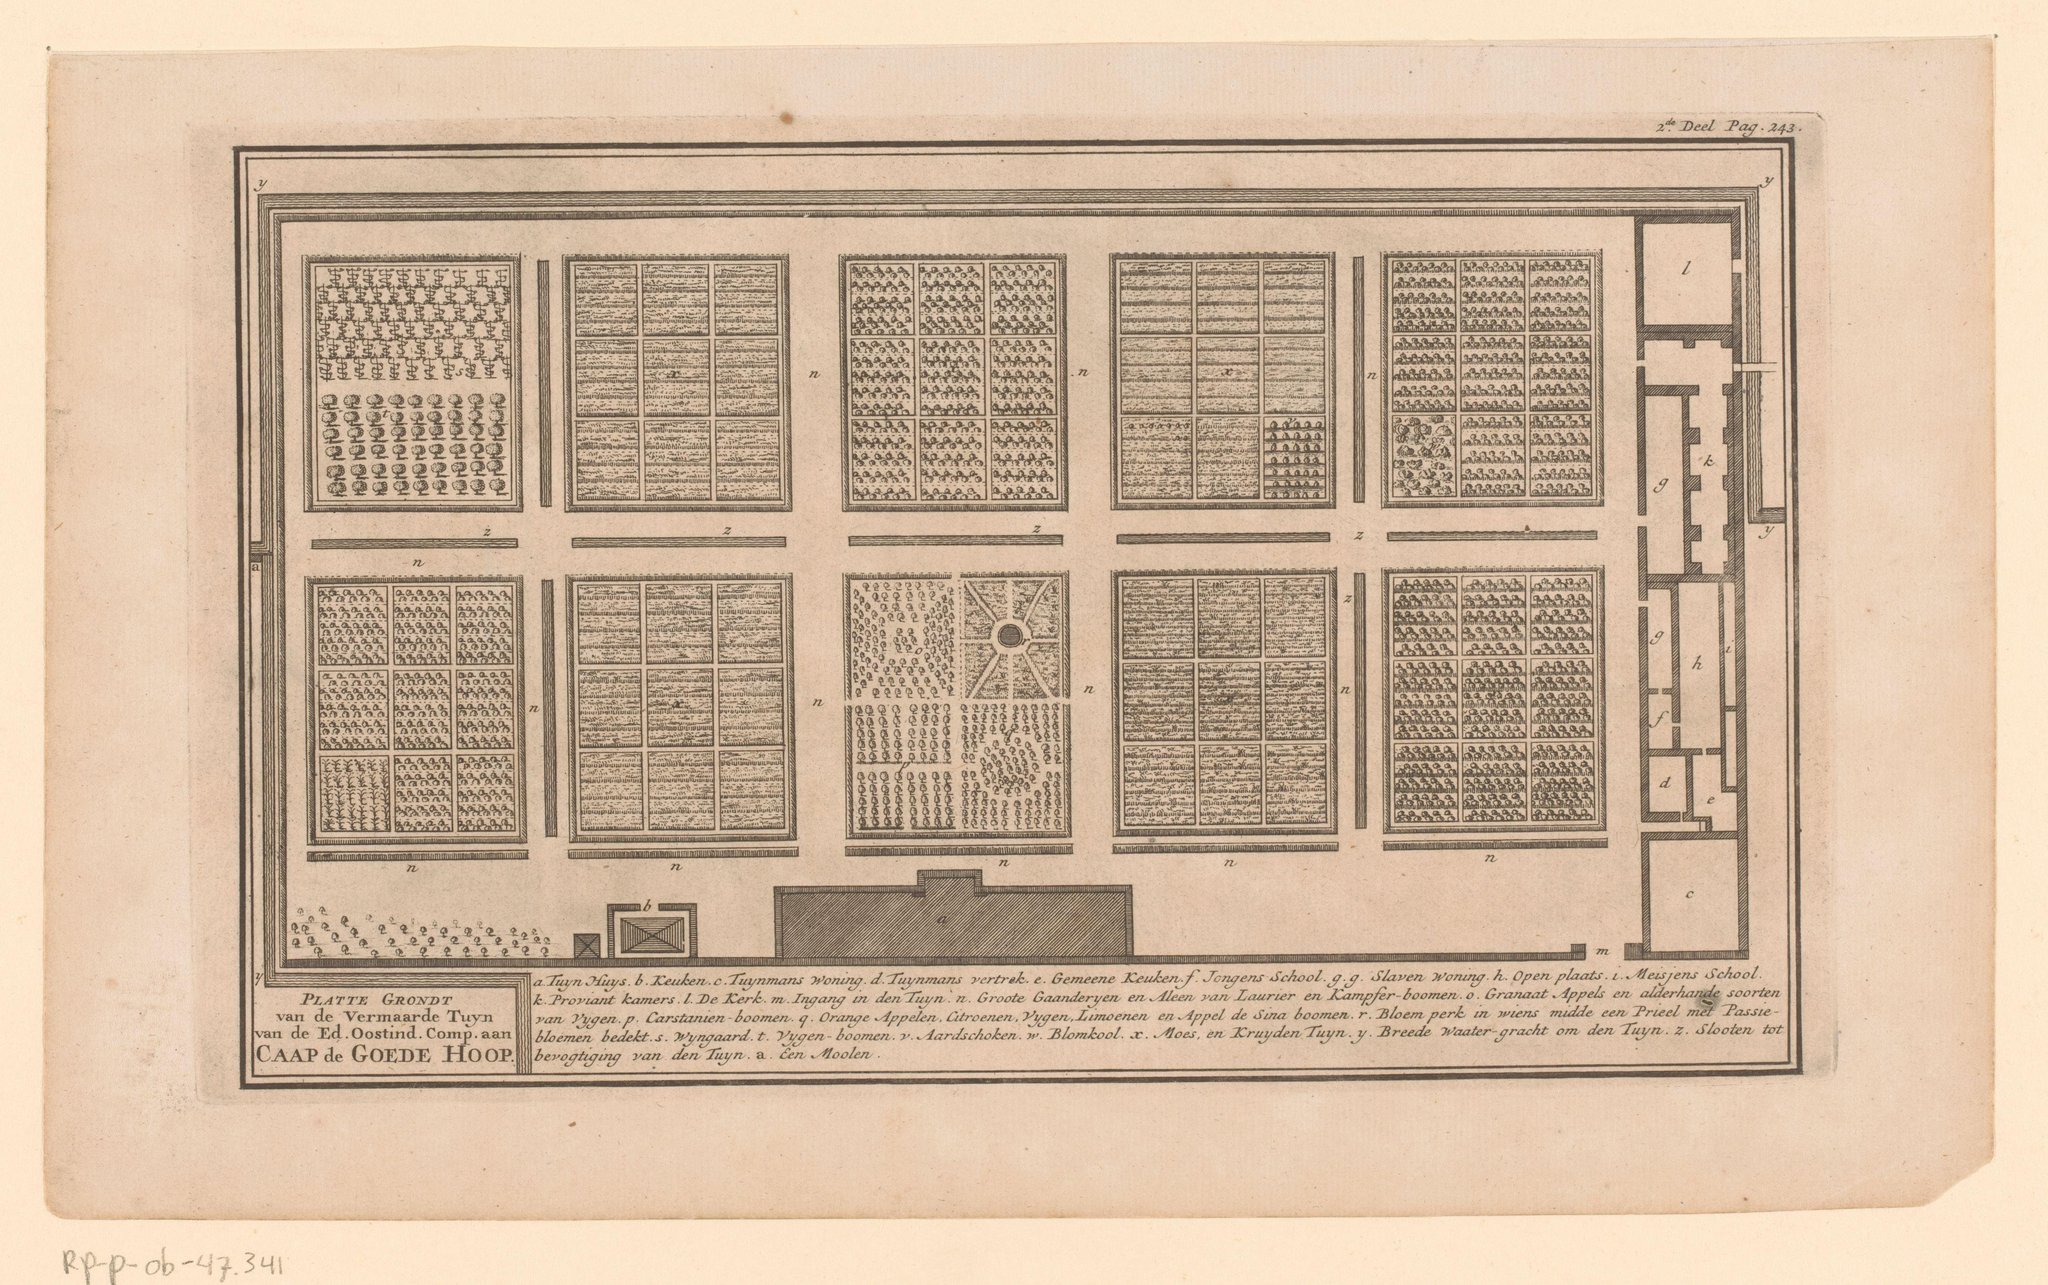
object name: area plan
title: Platte Grondt van de Vermaarde Tuyn van de Ed. Oostind. Comp. aan Caap de Goede Hoop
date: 1727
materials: paper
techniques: etching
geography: amsterdam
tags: plan, map of garden, garden, cape of good hope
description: Prent uit: Kolbe, Peter. Naaukeurige en Uitvoerige Beschryving van de Kaap de Goede Hoop (...). Amsterdam: Balthazar Lakeman, 1727, dl. 2, p. 243.